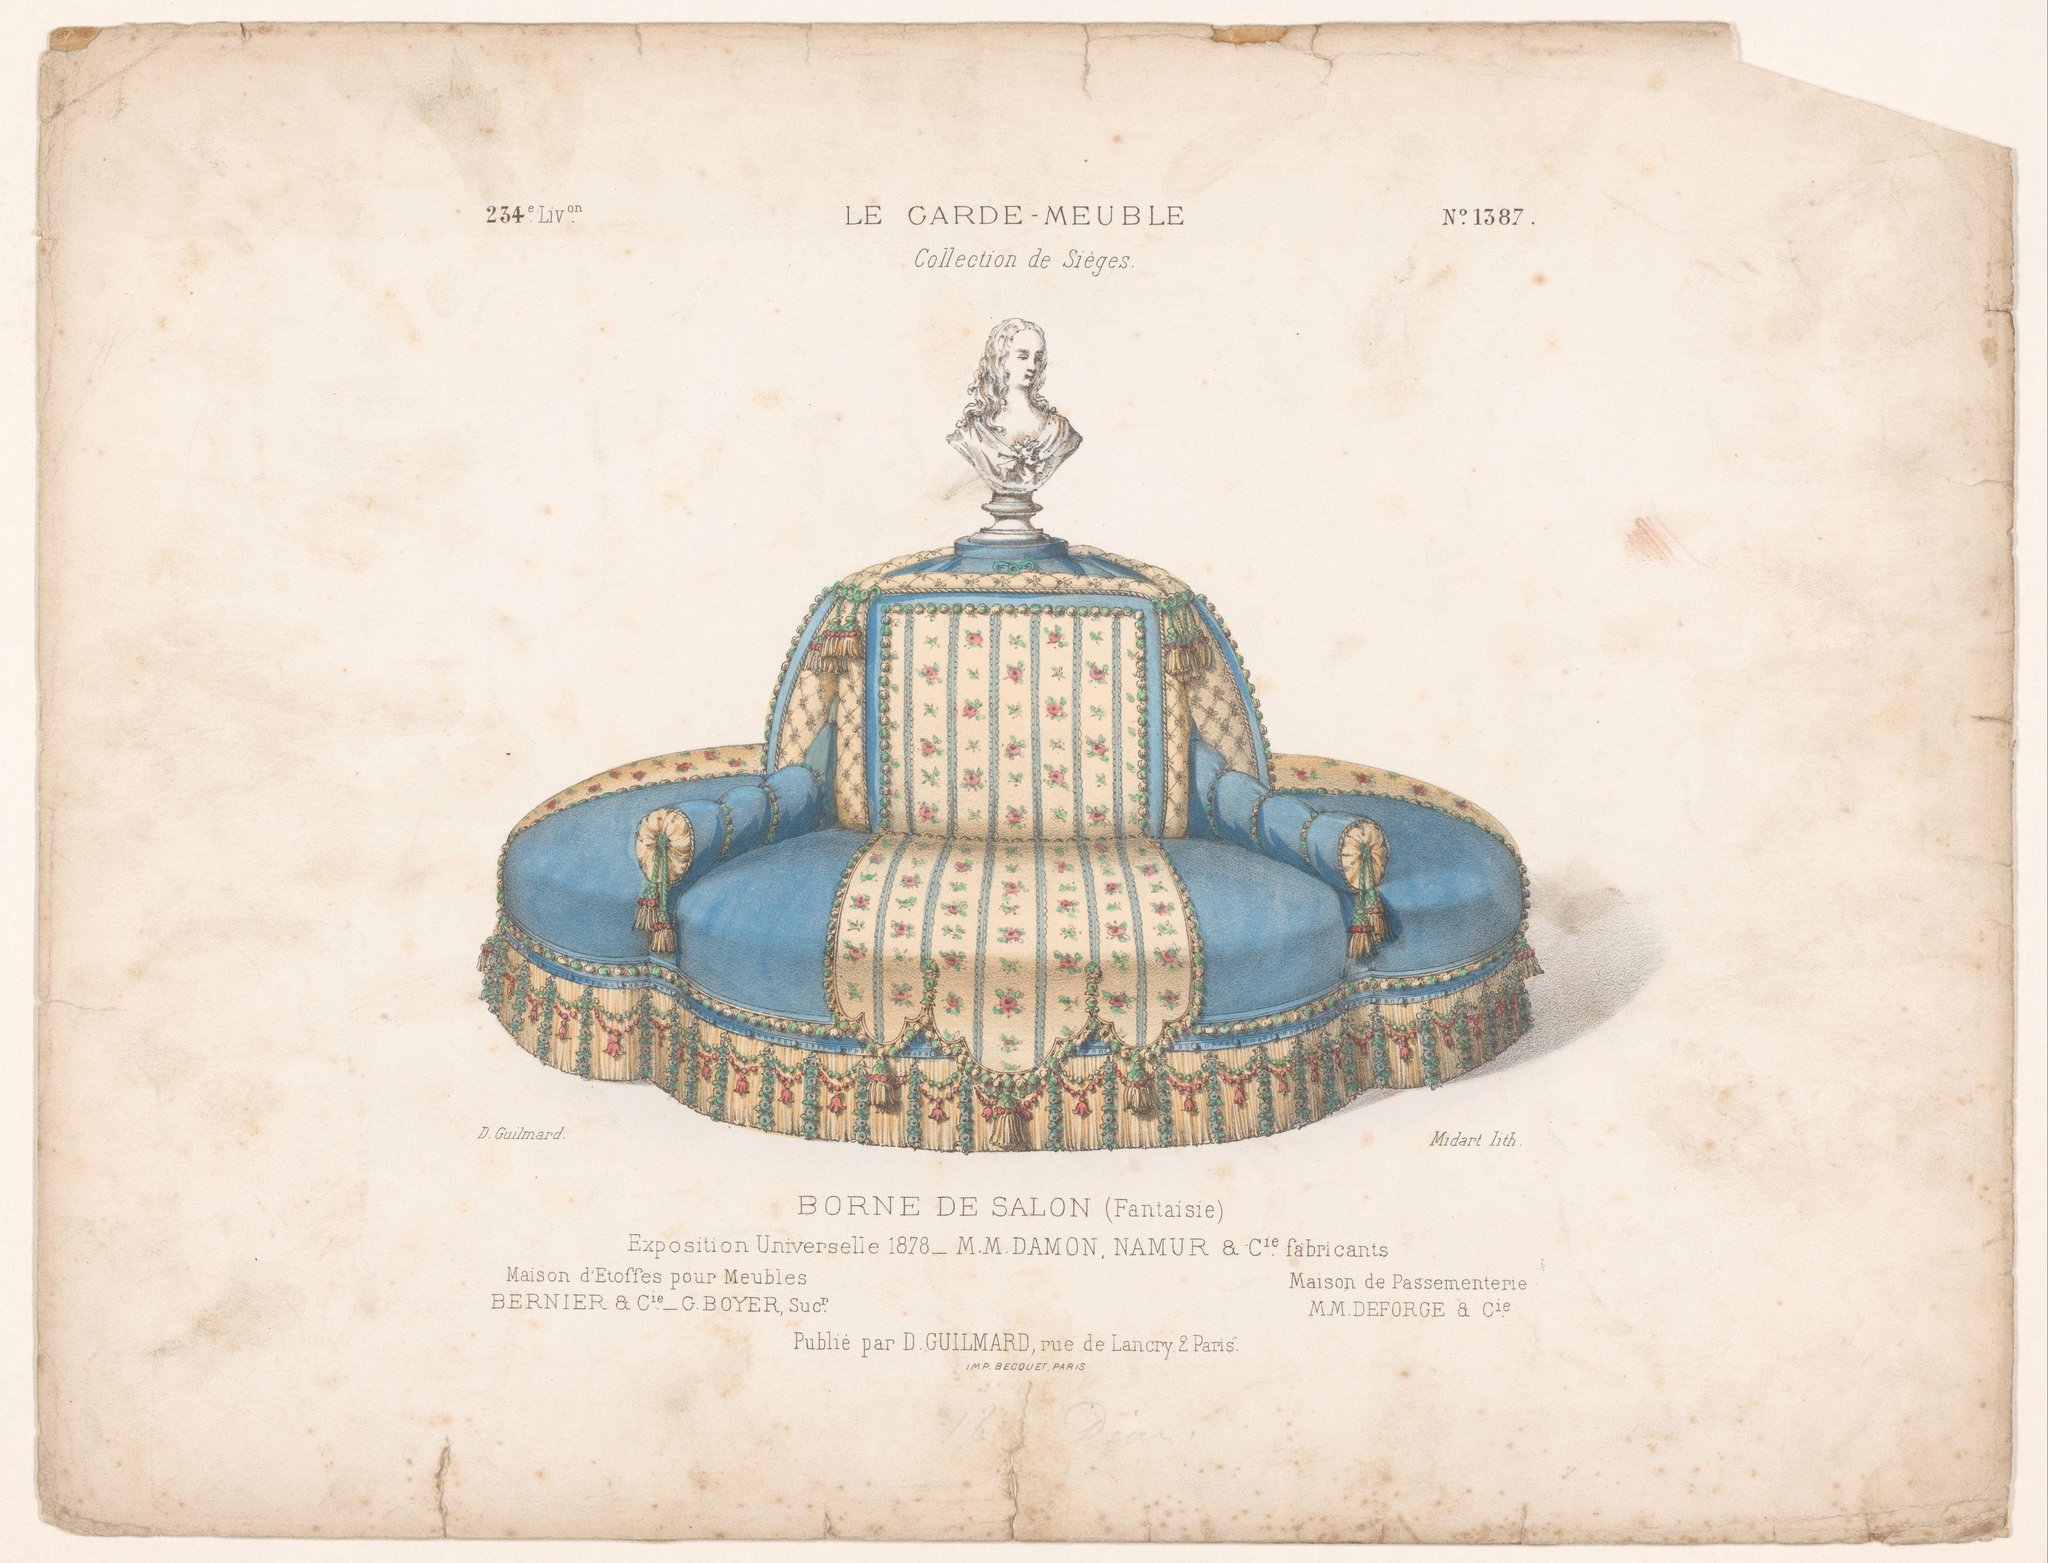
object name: print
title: Ronde bank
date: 1839-1885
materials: paper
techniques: hand coloring, lithograph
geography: paris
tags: seating furniture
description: Ieder Livraison in de serie Le Garde-Meuble bevat negen platen: drie 'sièges' (zitmeubels), drie 'meubles' (diverse meubels zoals tafels en kasten) en drie 'tentures' (gordijnen en draperieën).